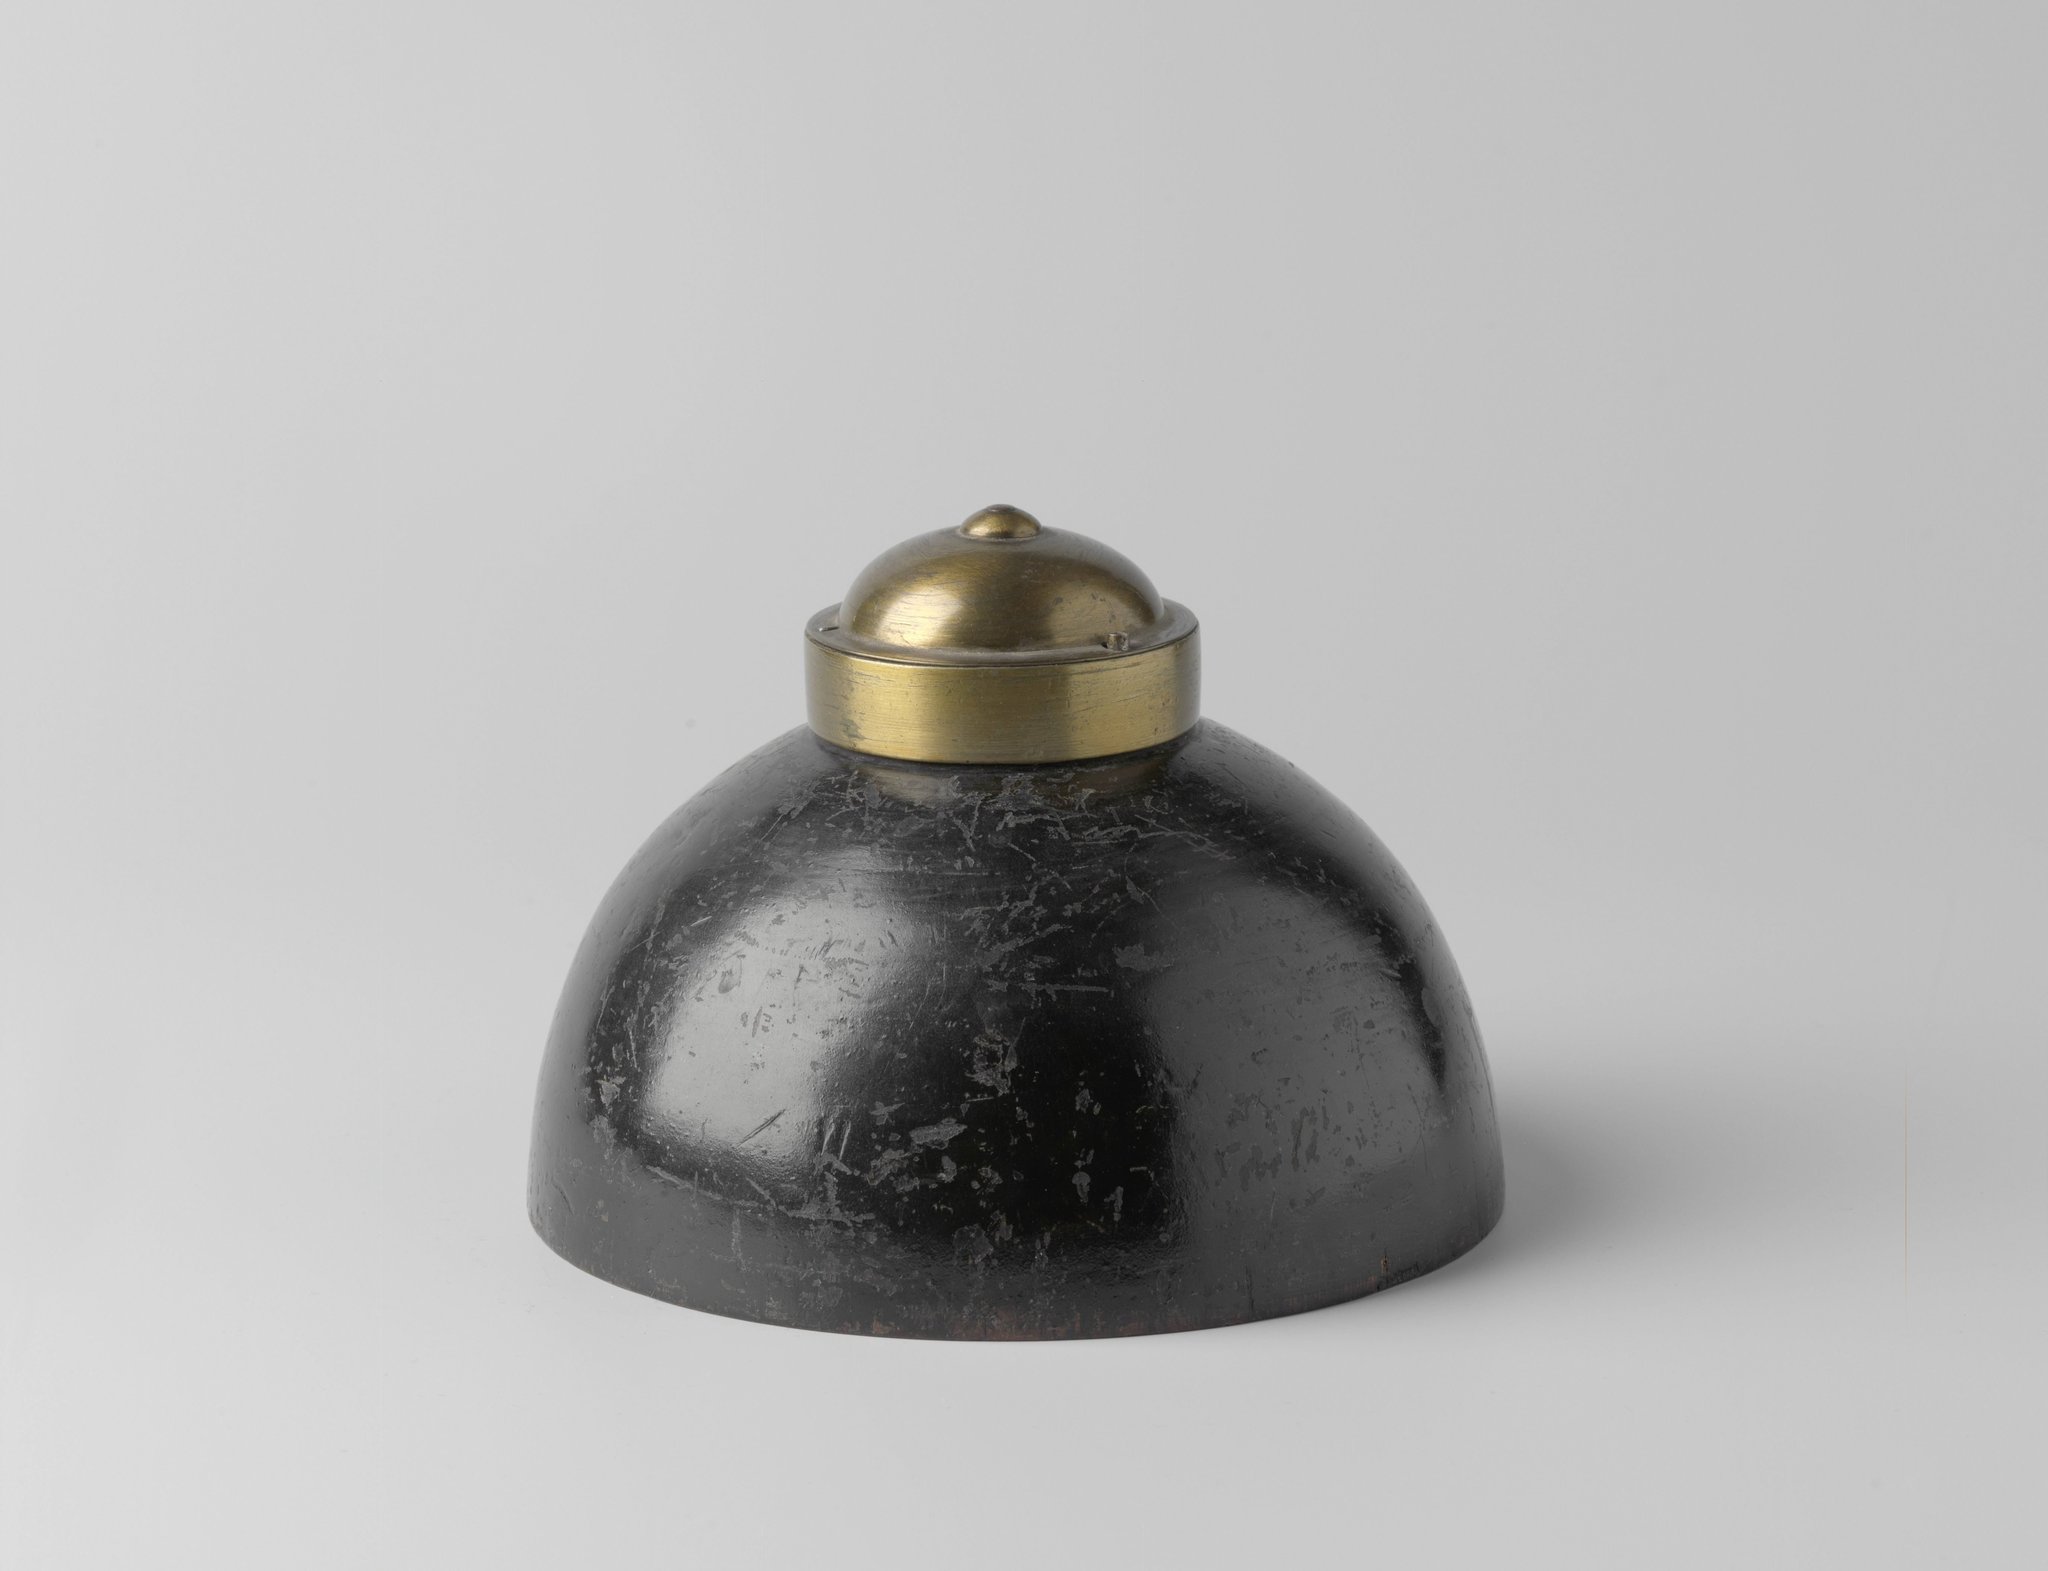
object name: scale model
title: Model van een ontstekingsmechanisme voor ronde granaten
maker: Anonymous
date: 1850-1900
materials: brass, wood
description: Halve houten bol die de bovenzijde van een granaat voorstelt met daarop bevestigd een ontstekingsmechanisme, mogelijk een zogenaamde Buis van Bourbon, maar groter en grover uitgevoerd dan bekende ontstekingsmechanismen van dit ontwerp.